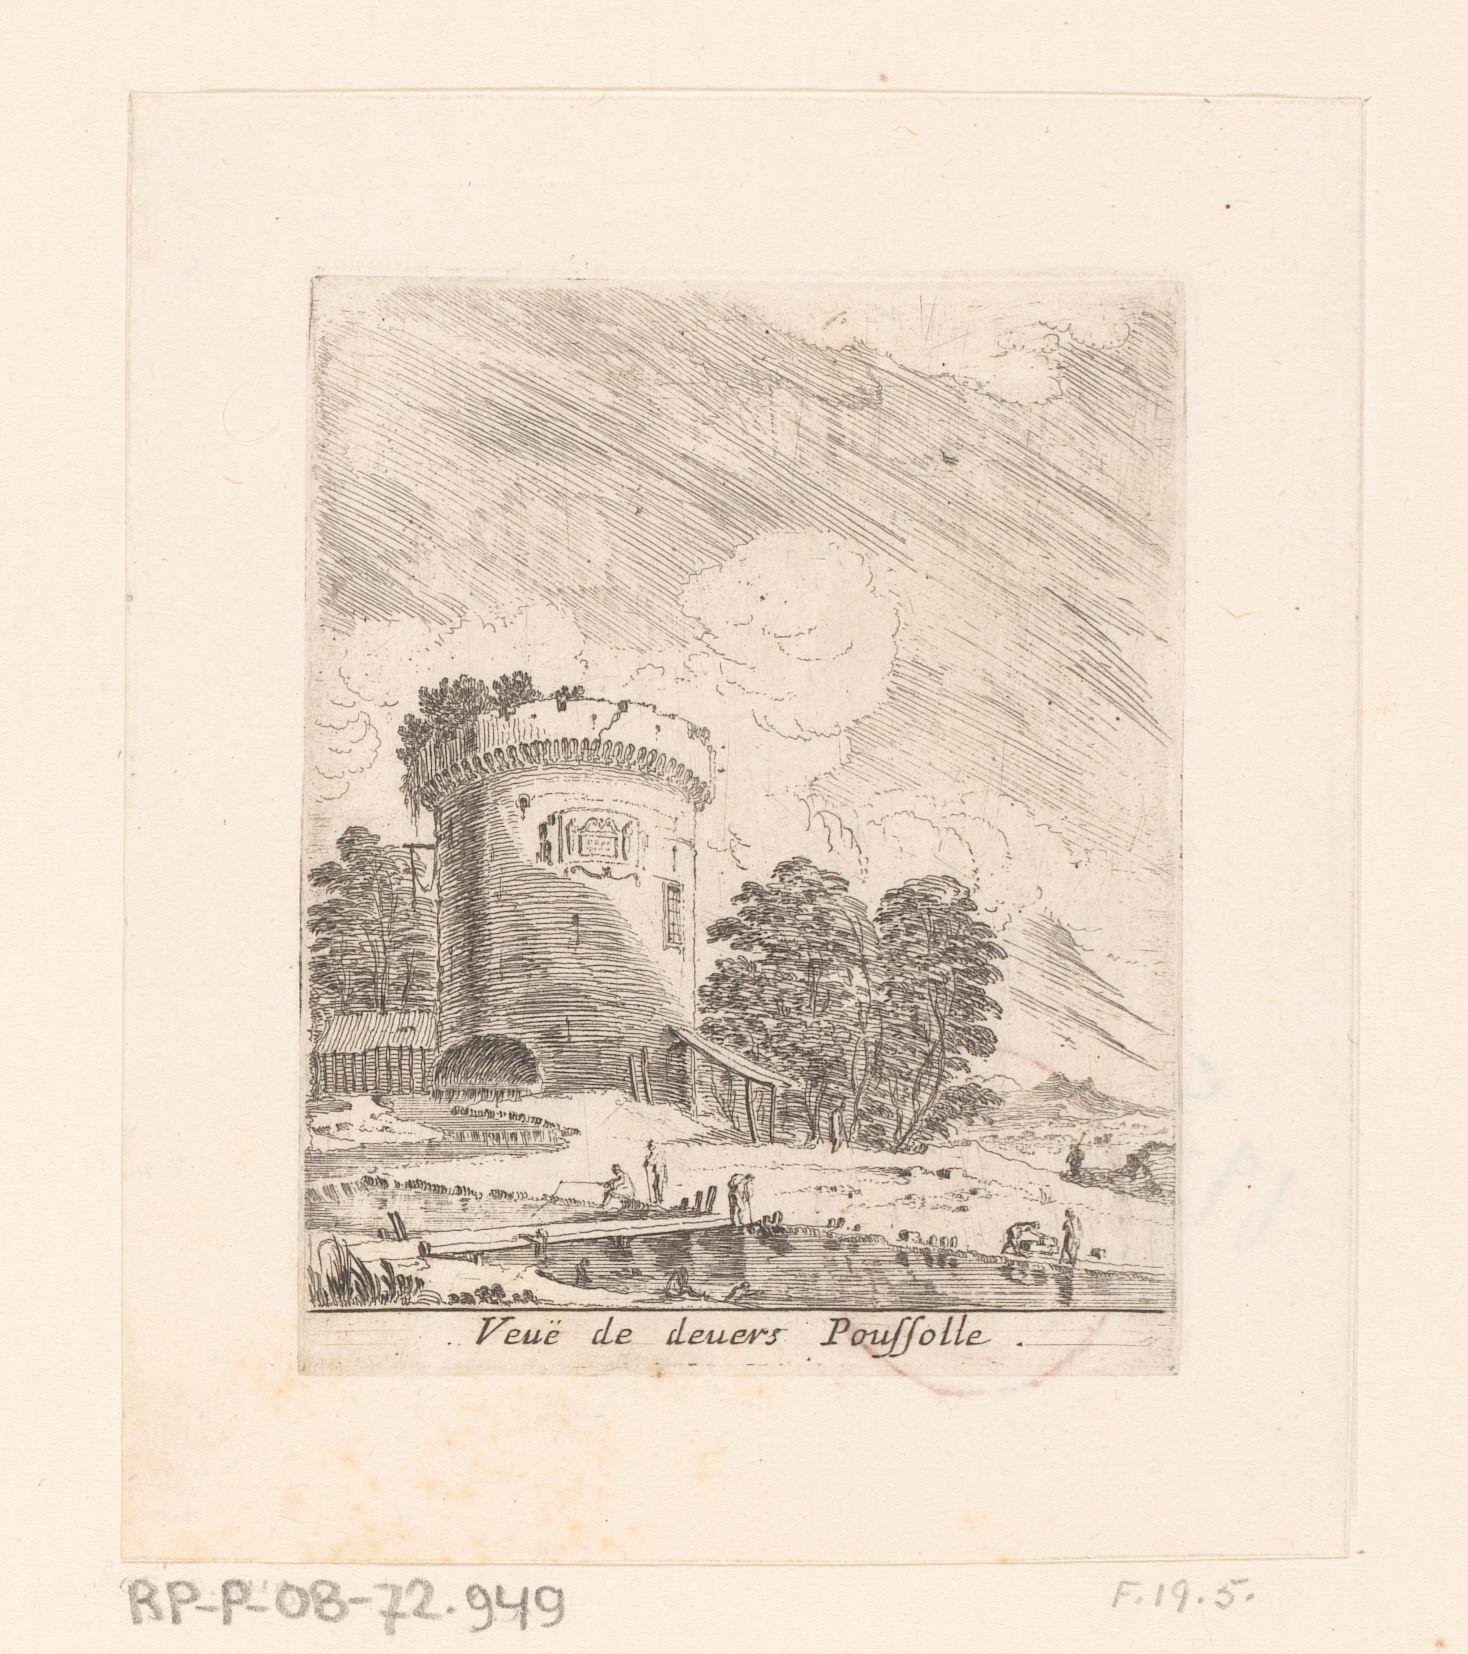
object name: print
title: Veue de devers Poussole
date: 1631-1661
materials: paper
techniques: etching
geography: france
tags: landscape with tower or castle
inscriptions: collector's mark: Lugt 240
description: Prent maakt deel uit van een ongenummerde serie van 22 prenten.